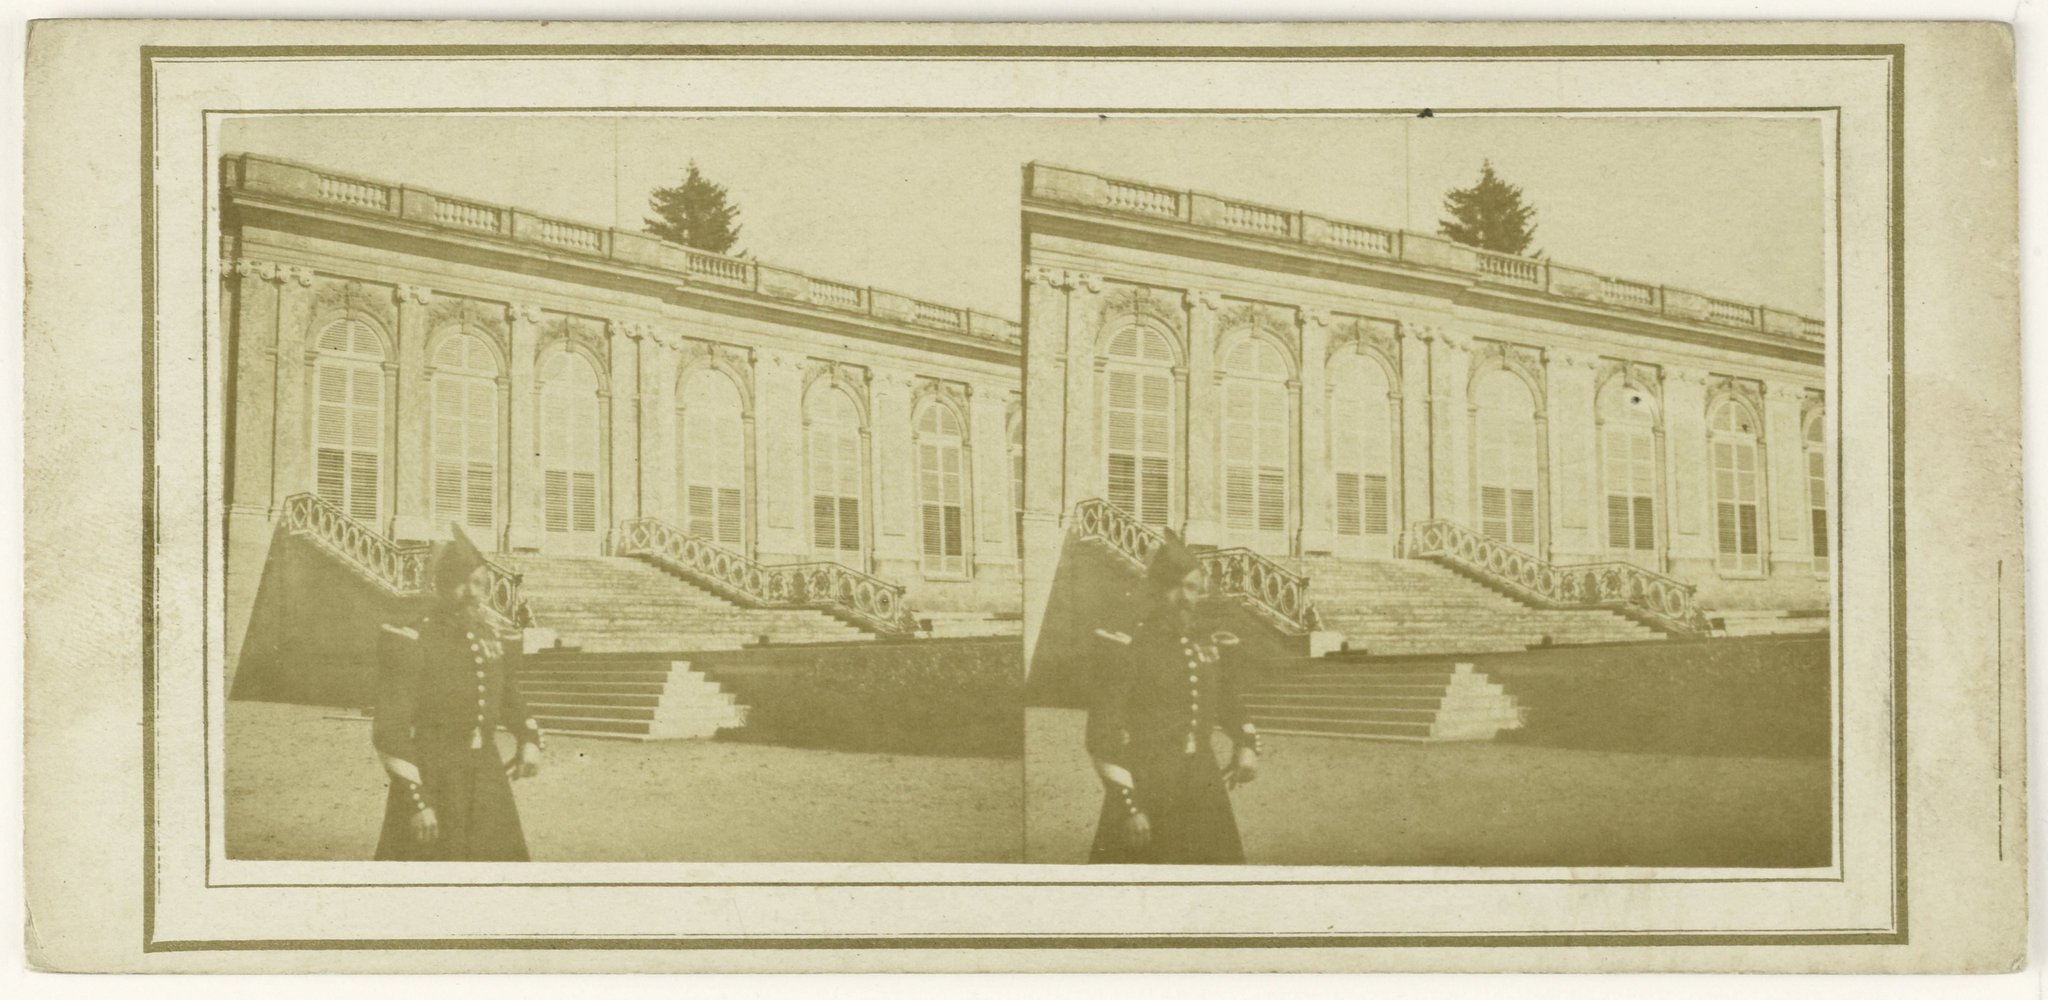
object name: stereograph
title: Gezicht op het Paleis van Versailles met een man in uniform op de voorgrond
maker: Anonymous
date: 1855-1860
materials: cardboard, photographic support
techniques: albumen print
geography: versailles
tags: clothes for official occasions, palace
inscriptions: inscription: ‘Versailles’, number: ‘No. 22 Versailles 2’